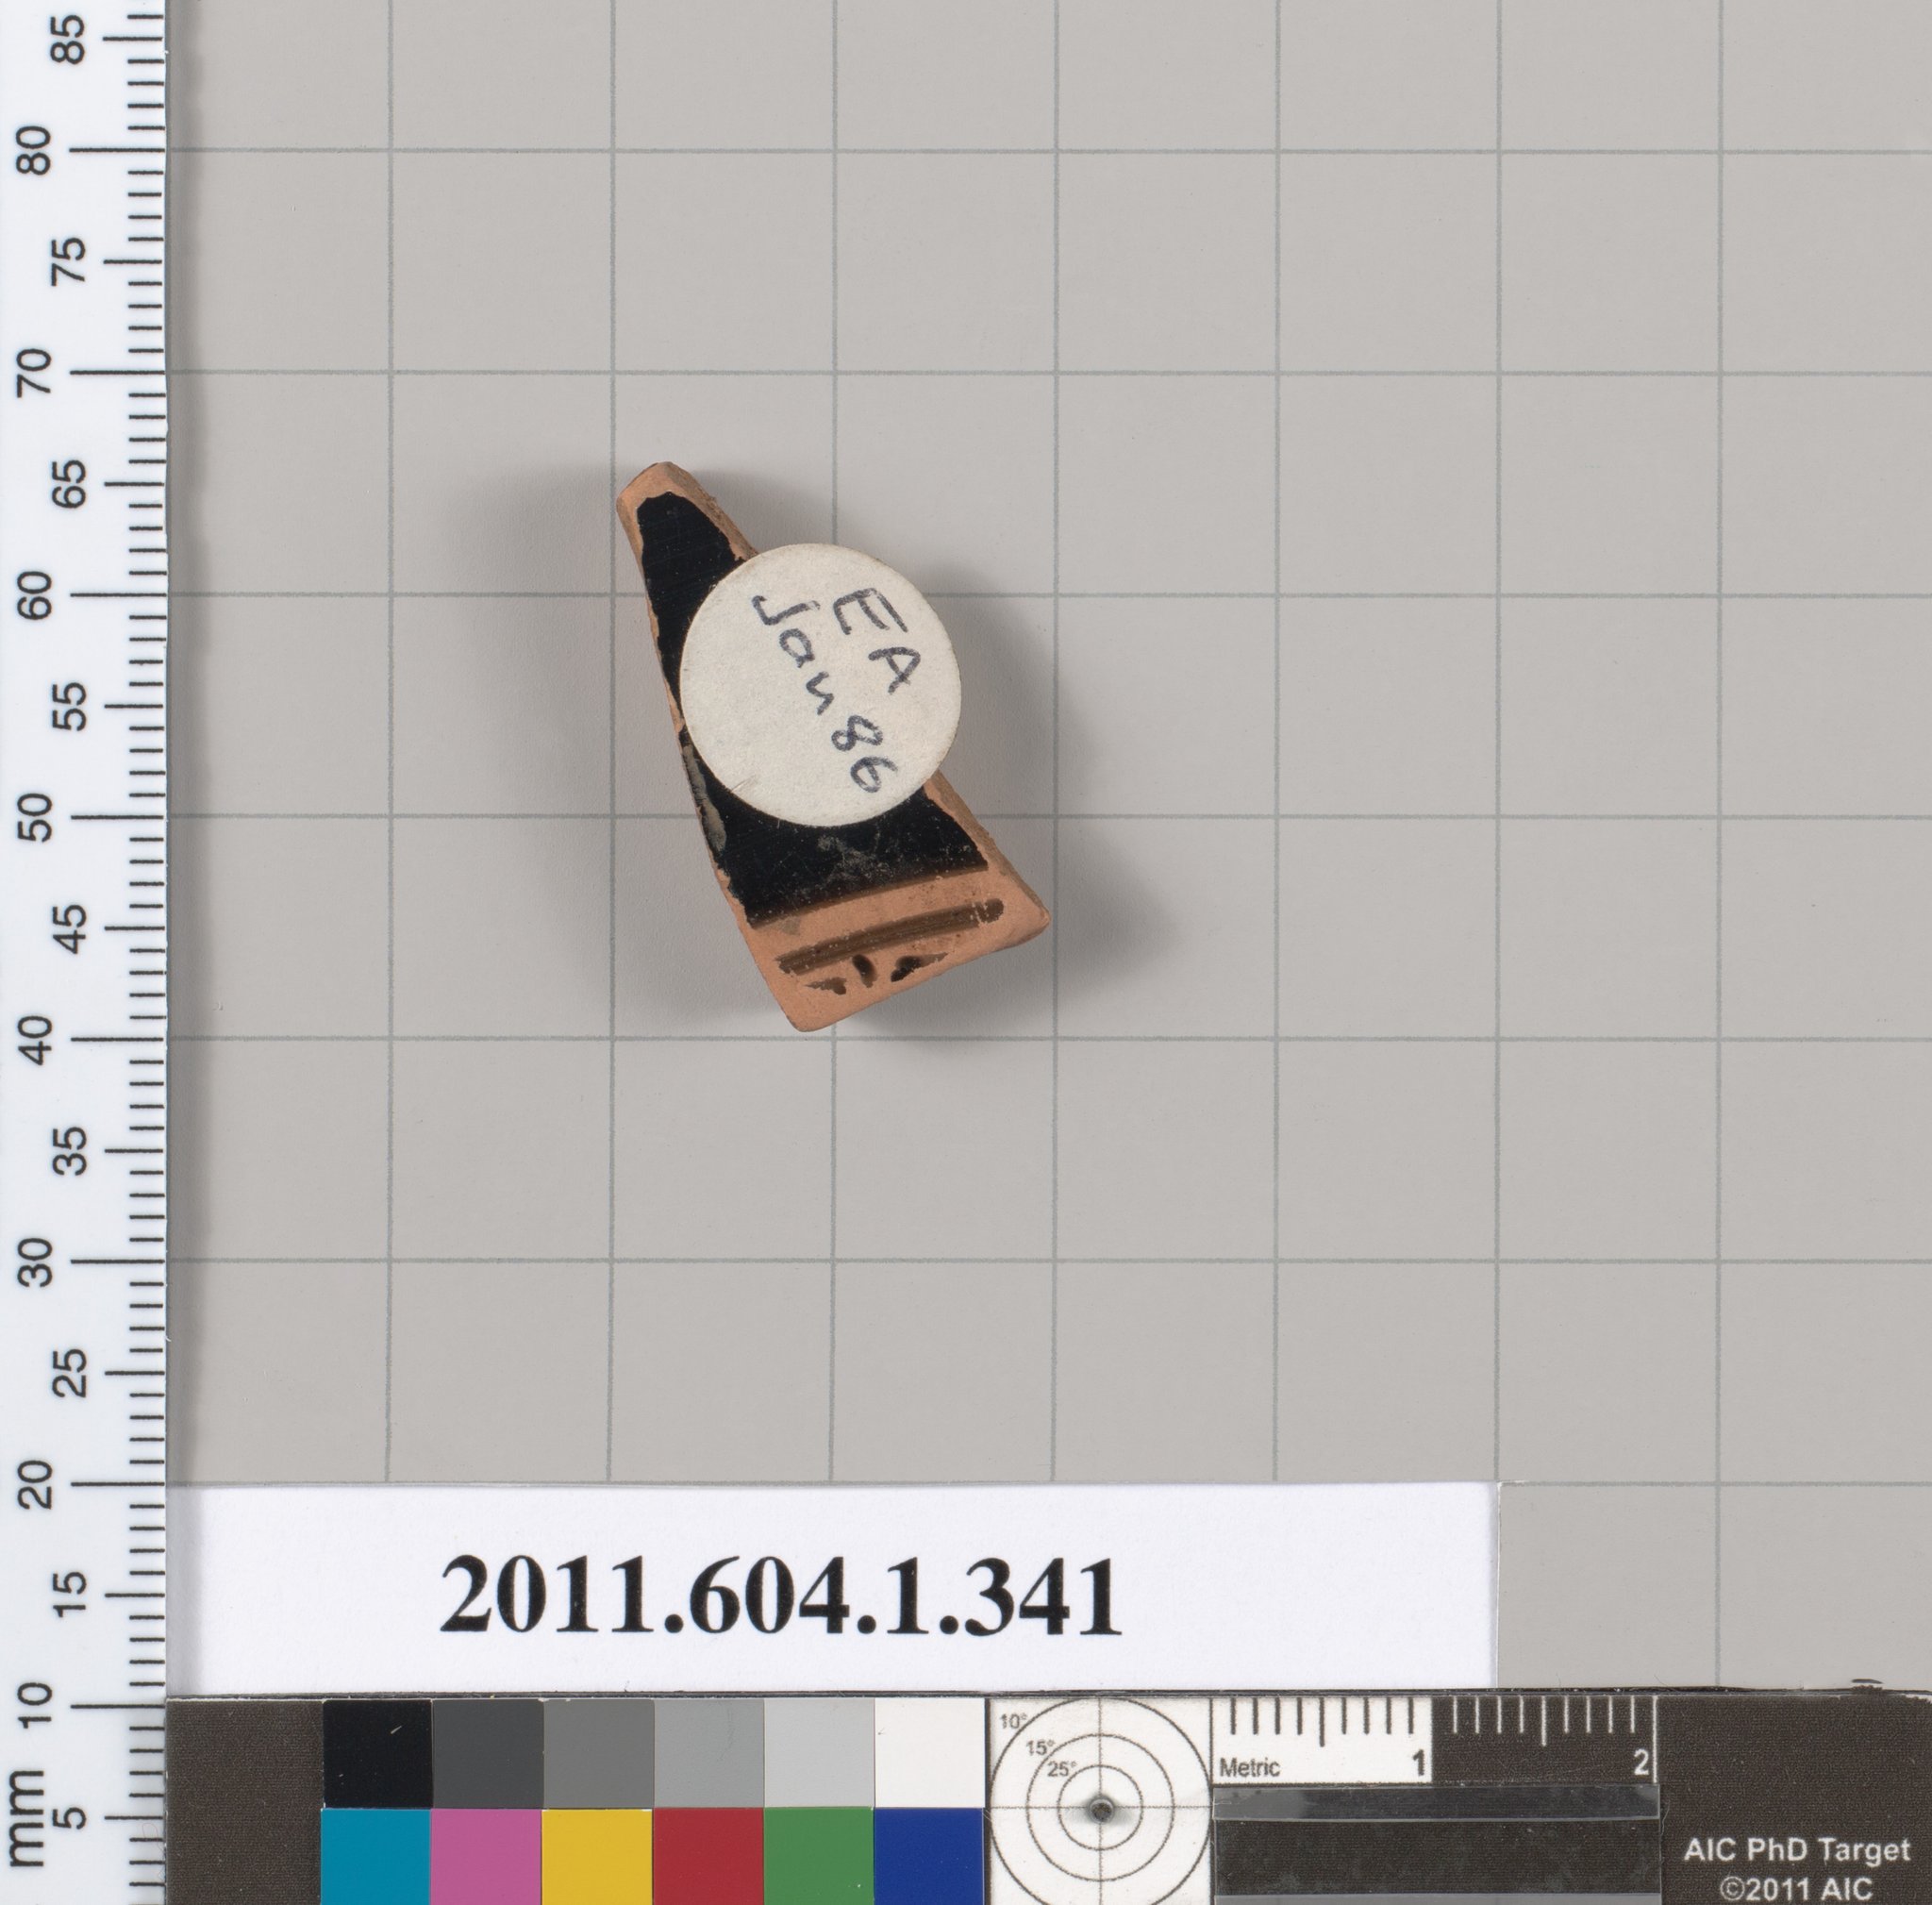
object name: kylix fragment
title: Terracotta fragment of a kylix (drinking cup)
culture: greek, attic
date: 475-451 BCE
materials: terracotta